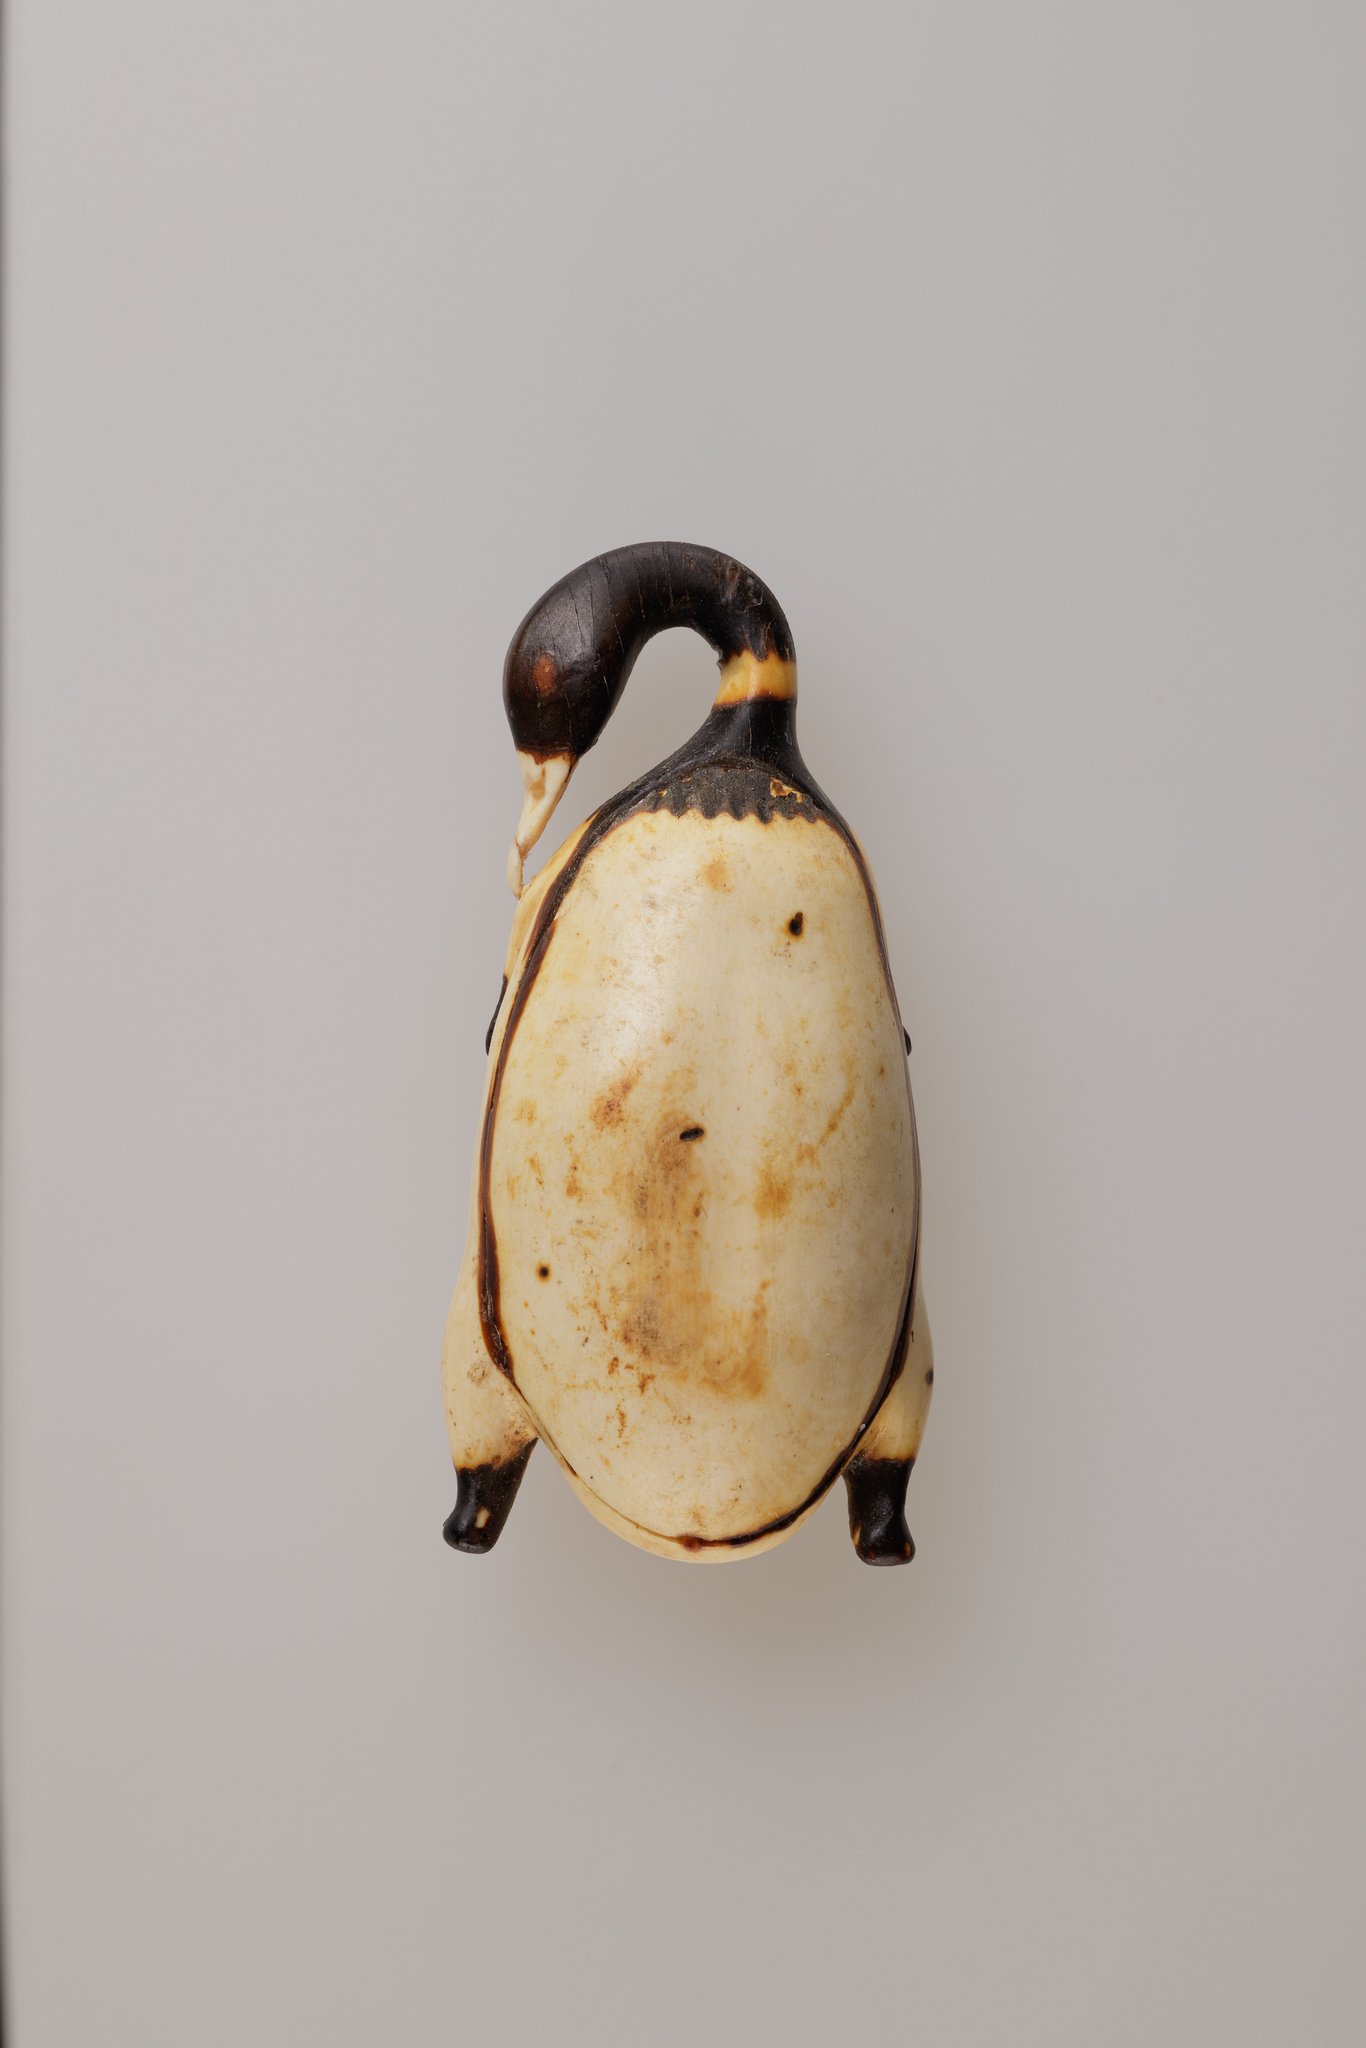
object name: cosmetic dish, duck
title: Cosmetic Dish in the Shape of a Trussed Duck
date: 1353-1327 BCE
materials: paint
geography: egypt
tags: ducks